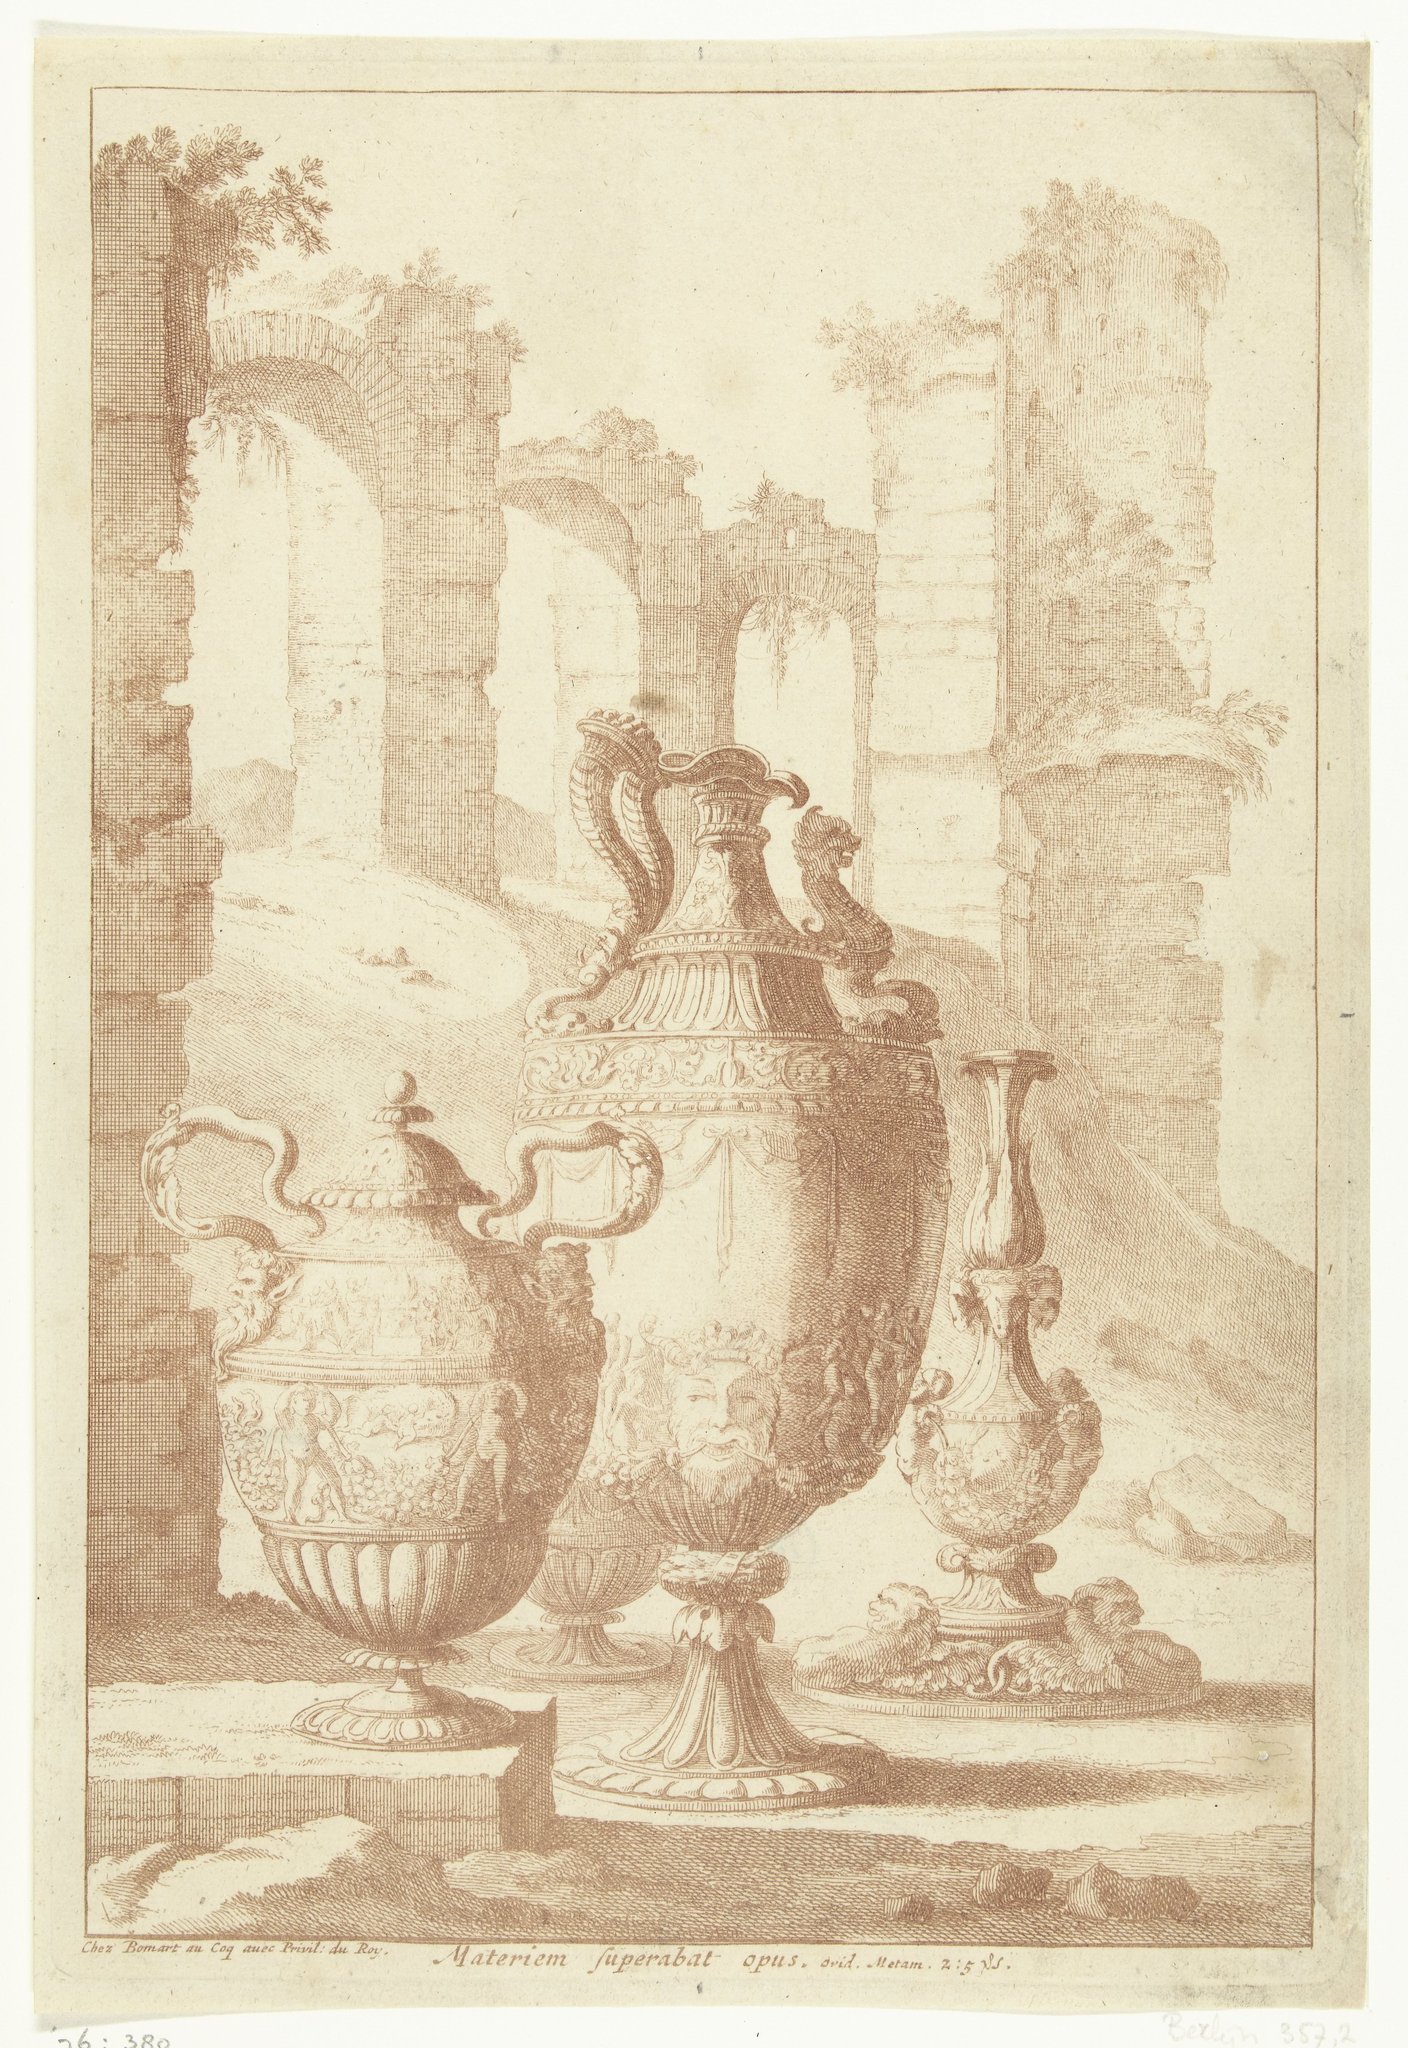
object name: ornament print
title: Materiem superabat opus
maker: Anonymous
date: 1688-1697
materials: paper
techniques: etching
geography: nijmegen